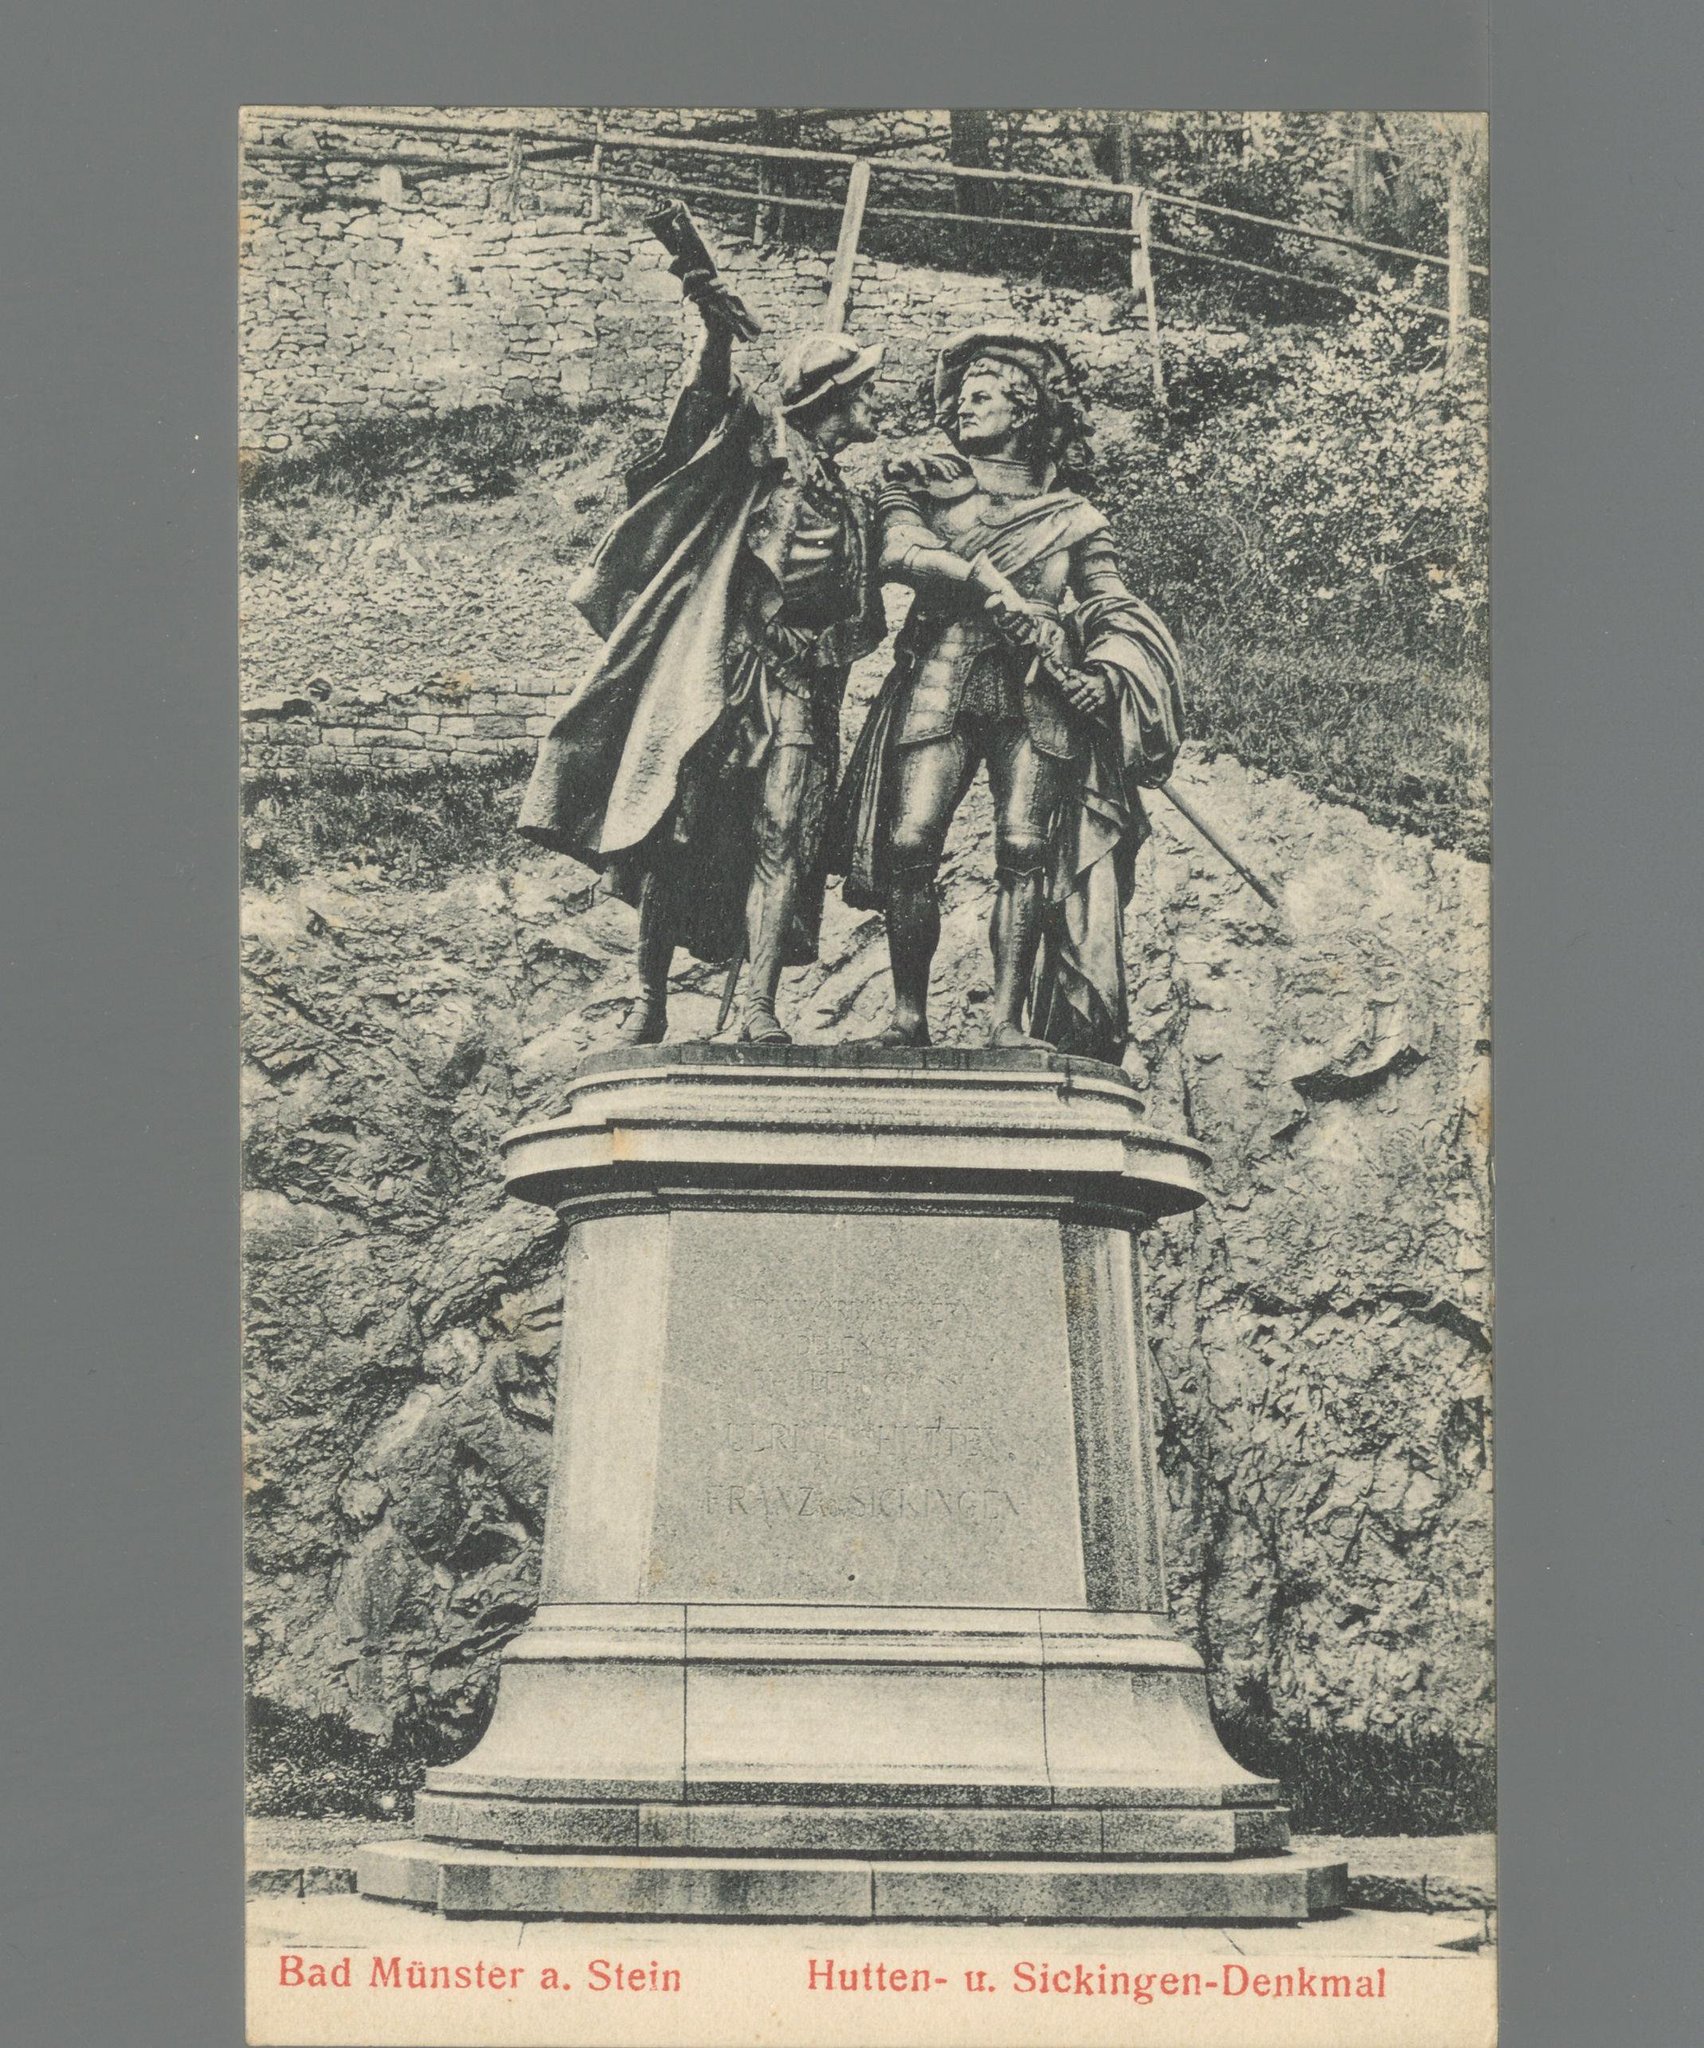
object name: ansichtkaart, prentbriefkaart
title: Bad Münster a. Stein. Hutten- u. Sickingen-Denkmal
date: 1906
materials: cardboard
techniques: photograph, writing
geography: bad münster am stein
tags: monument, statue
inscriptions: date